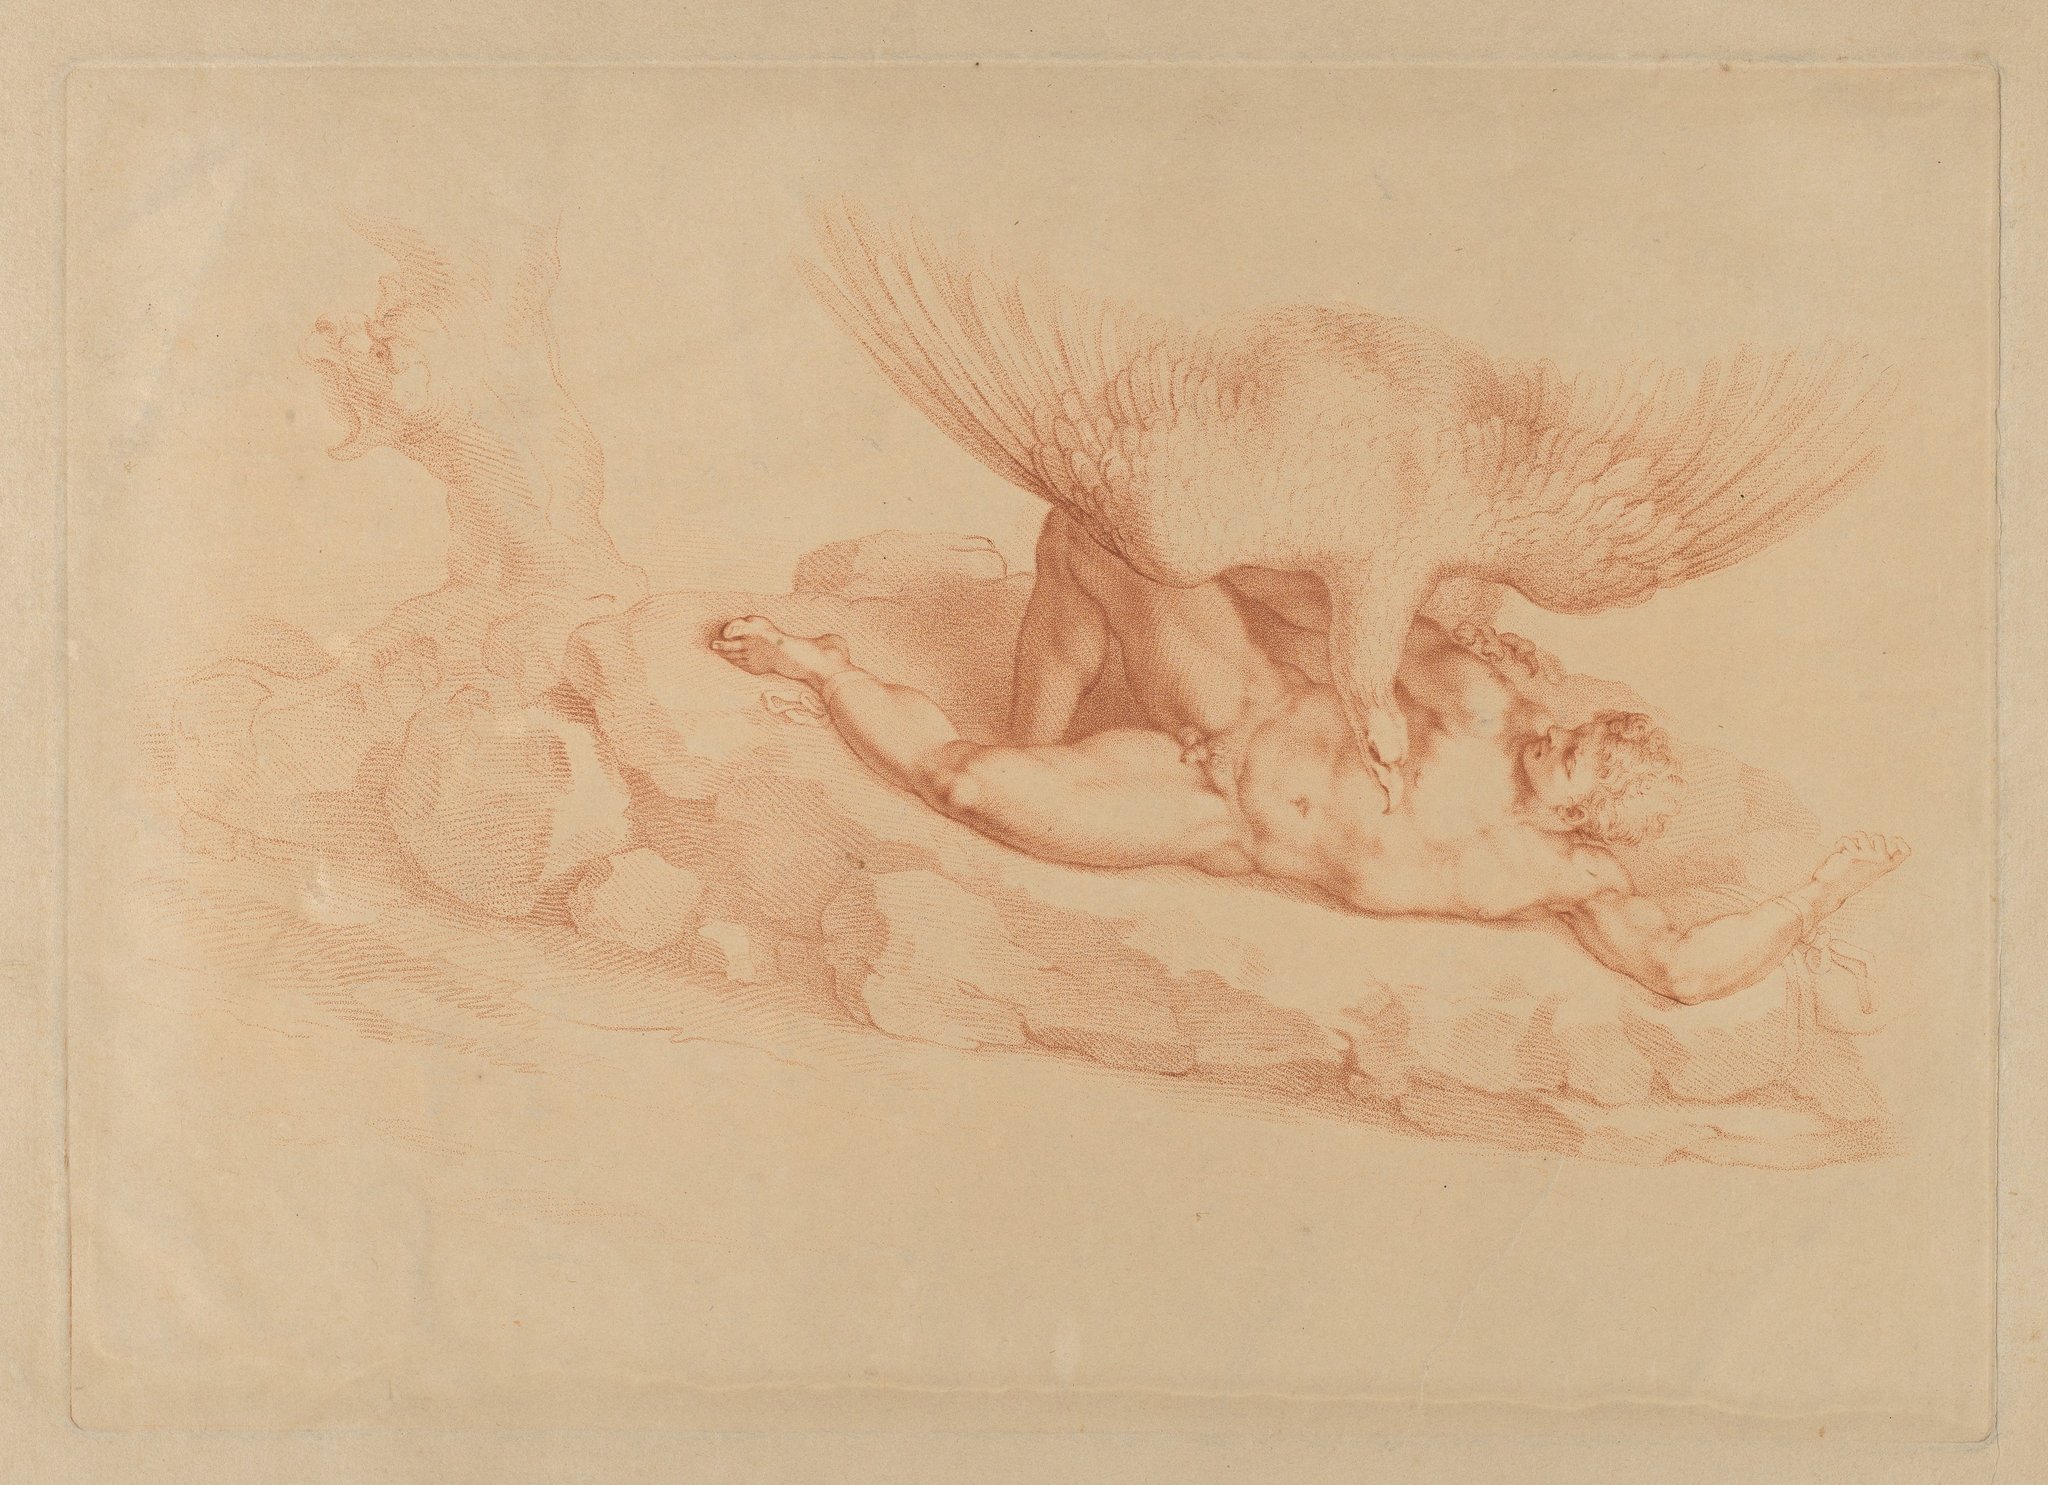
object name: print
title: Prometheus, naked, chained to a rock, looking up at an eagle standing over him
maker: francesco bartolozzi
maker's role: artist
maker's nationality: italian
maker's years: 1728-1815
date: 1795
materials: ink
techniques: printmaking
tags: eagles,male nudes